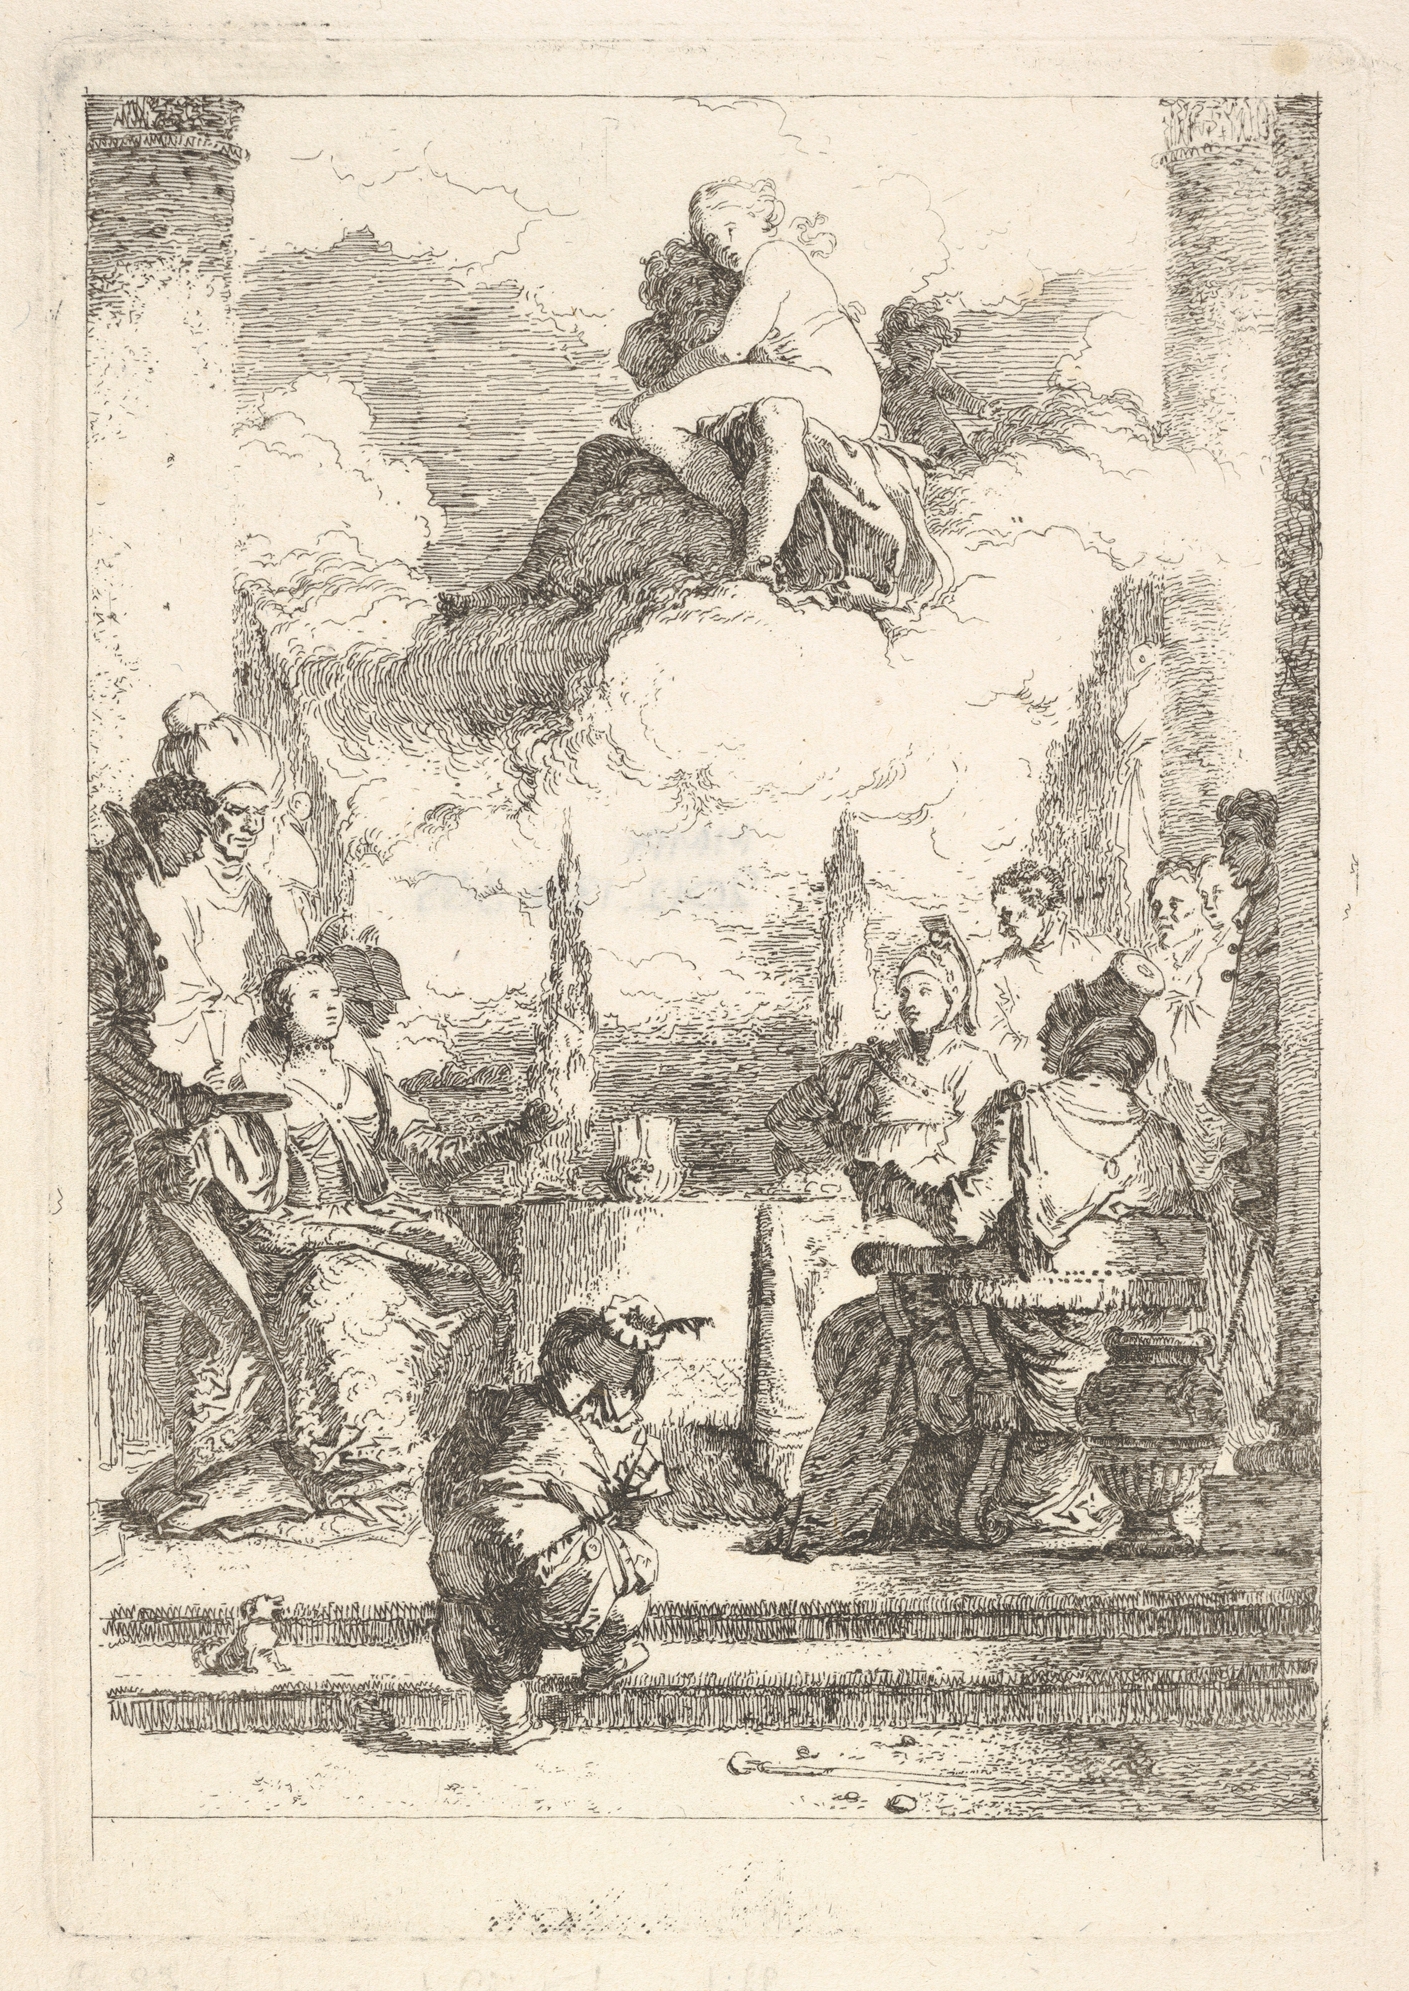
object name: print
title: The Banquet of Anthony and Cleopatra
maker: jean honoré fragonard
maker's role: artist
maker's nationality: french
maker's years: 1732-1806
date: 1764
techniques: etching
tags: cleopatra,men,banquets